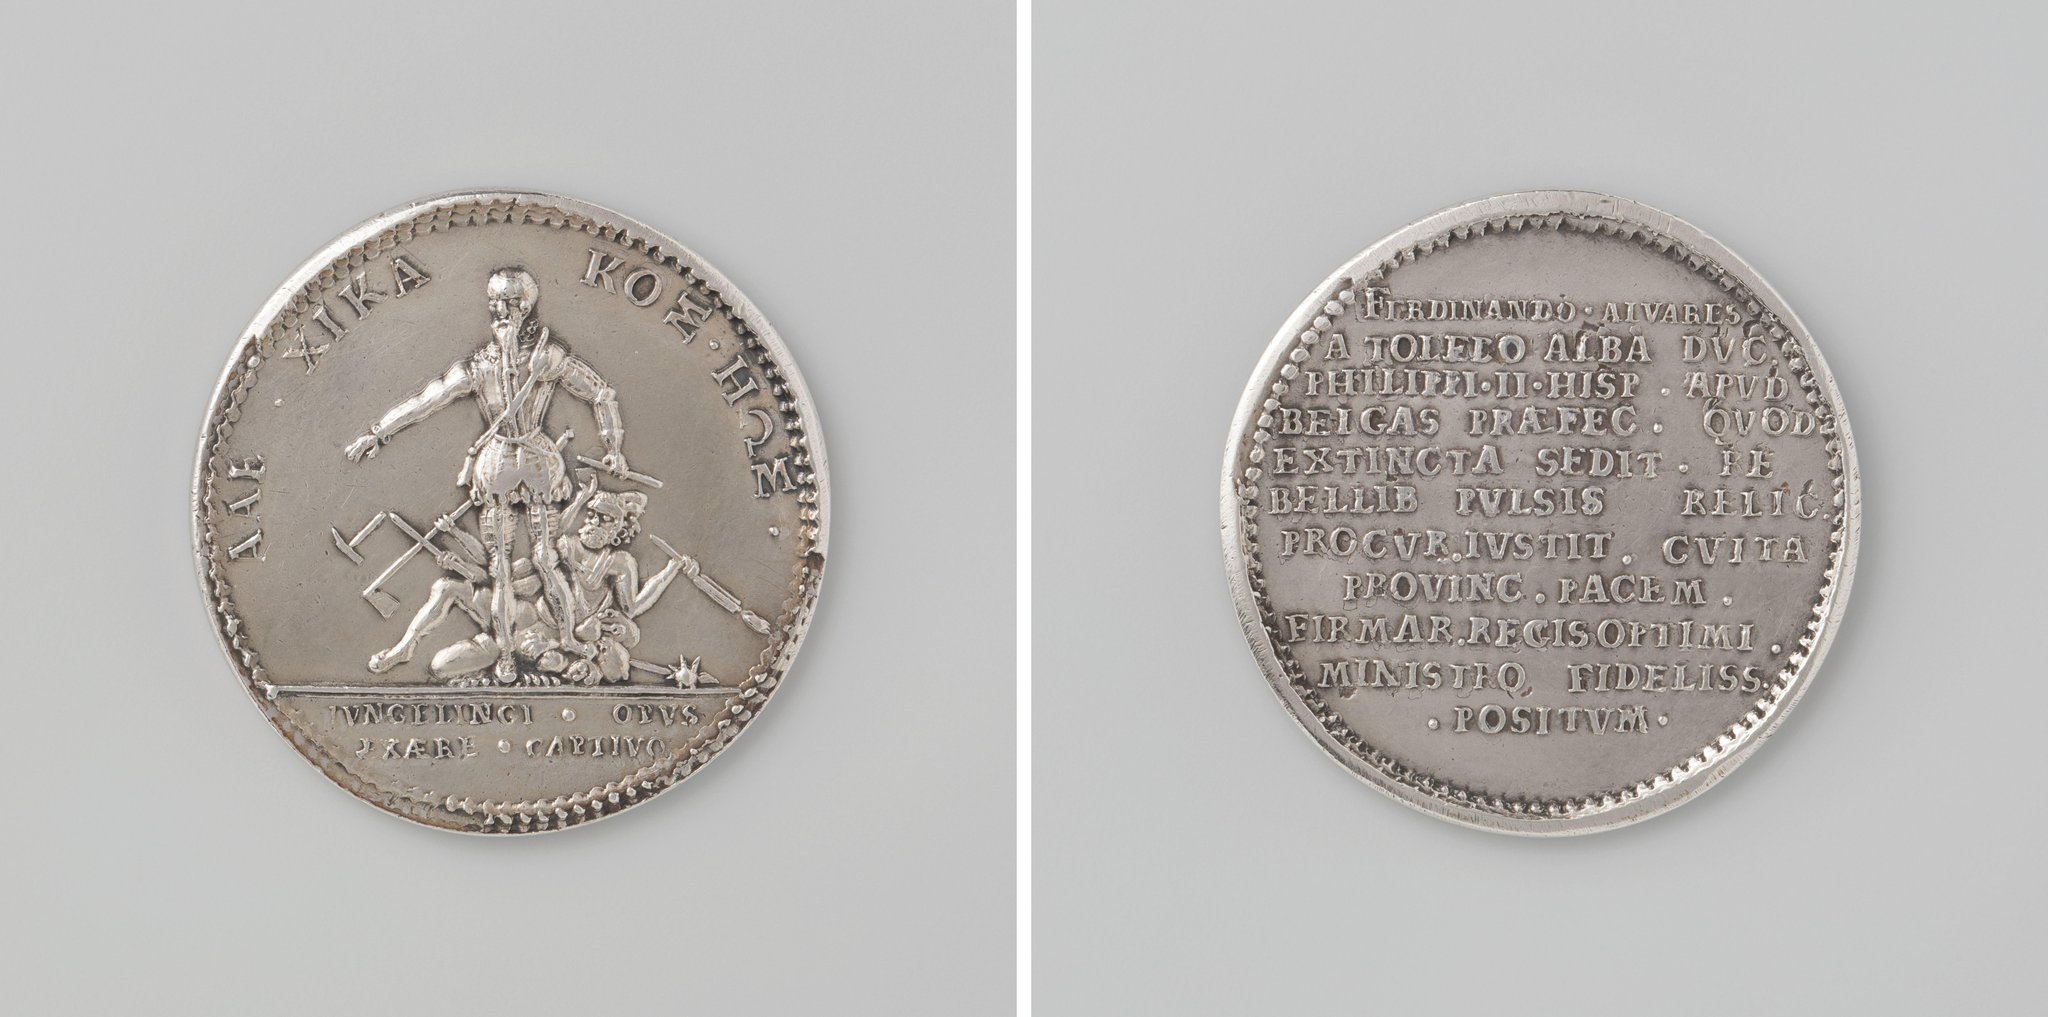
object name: history medal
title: Standbeeld, door Jacques Jonghelinck vervaardigd, voor de hertog van Alva opgericht in de citadel van Antwerpen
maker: nicolas chevalier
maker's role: print maker, publisher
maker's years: 1661-1720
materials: silver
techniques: striking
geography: netherlands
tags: fernando álvarez de toledo (3rd duke of alba), antwerp, jacques jonghelinck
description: Zilveren penning. Voorzijde: standbeeld van hertog van Alva met aan zijn voeten tweehoofdig gedrocht met vier armen binnen omschrift; afsnede: opschrift. Keerzijde opschrift.